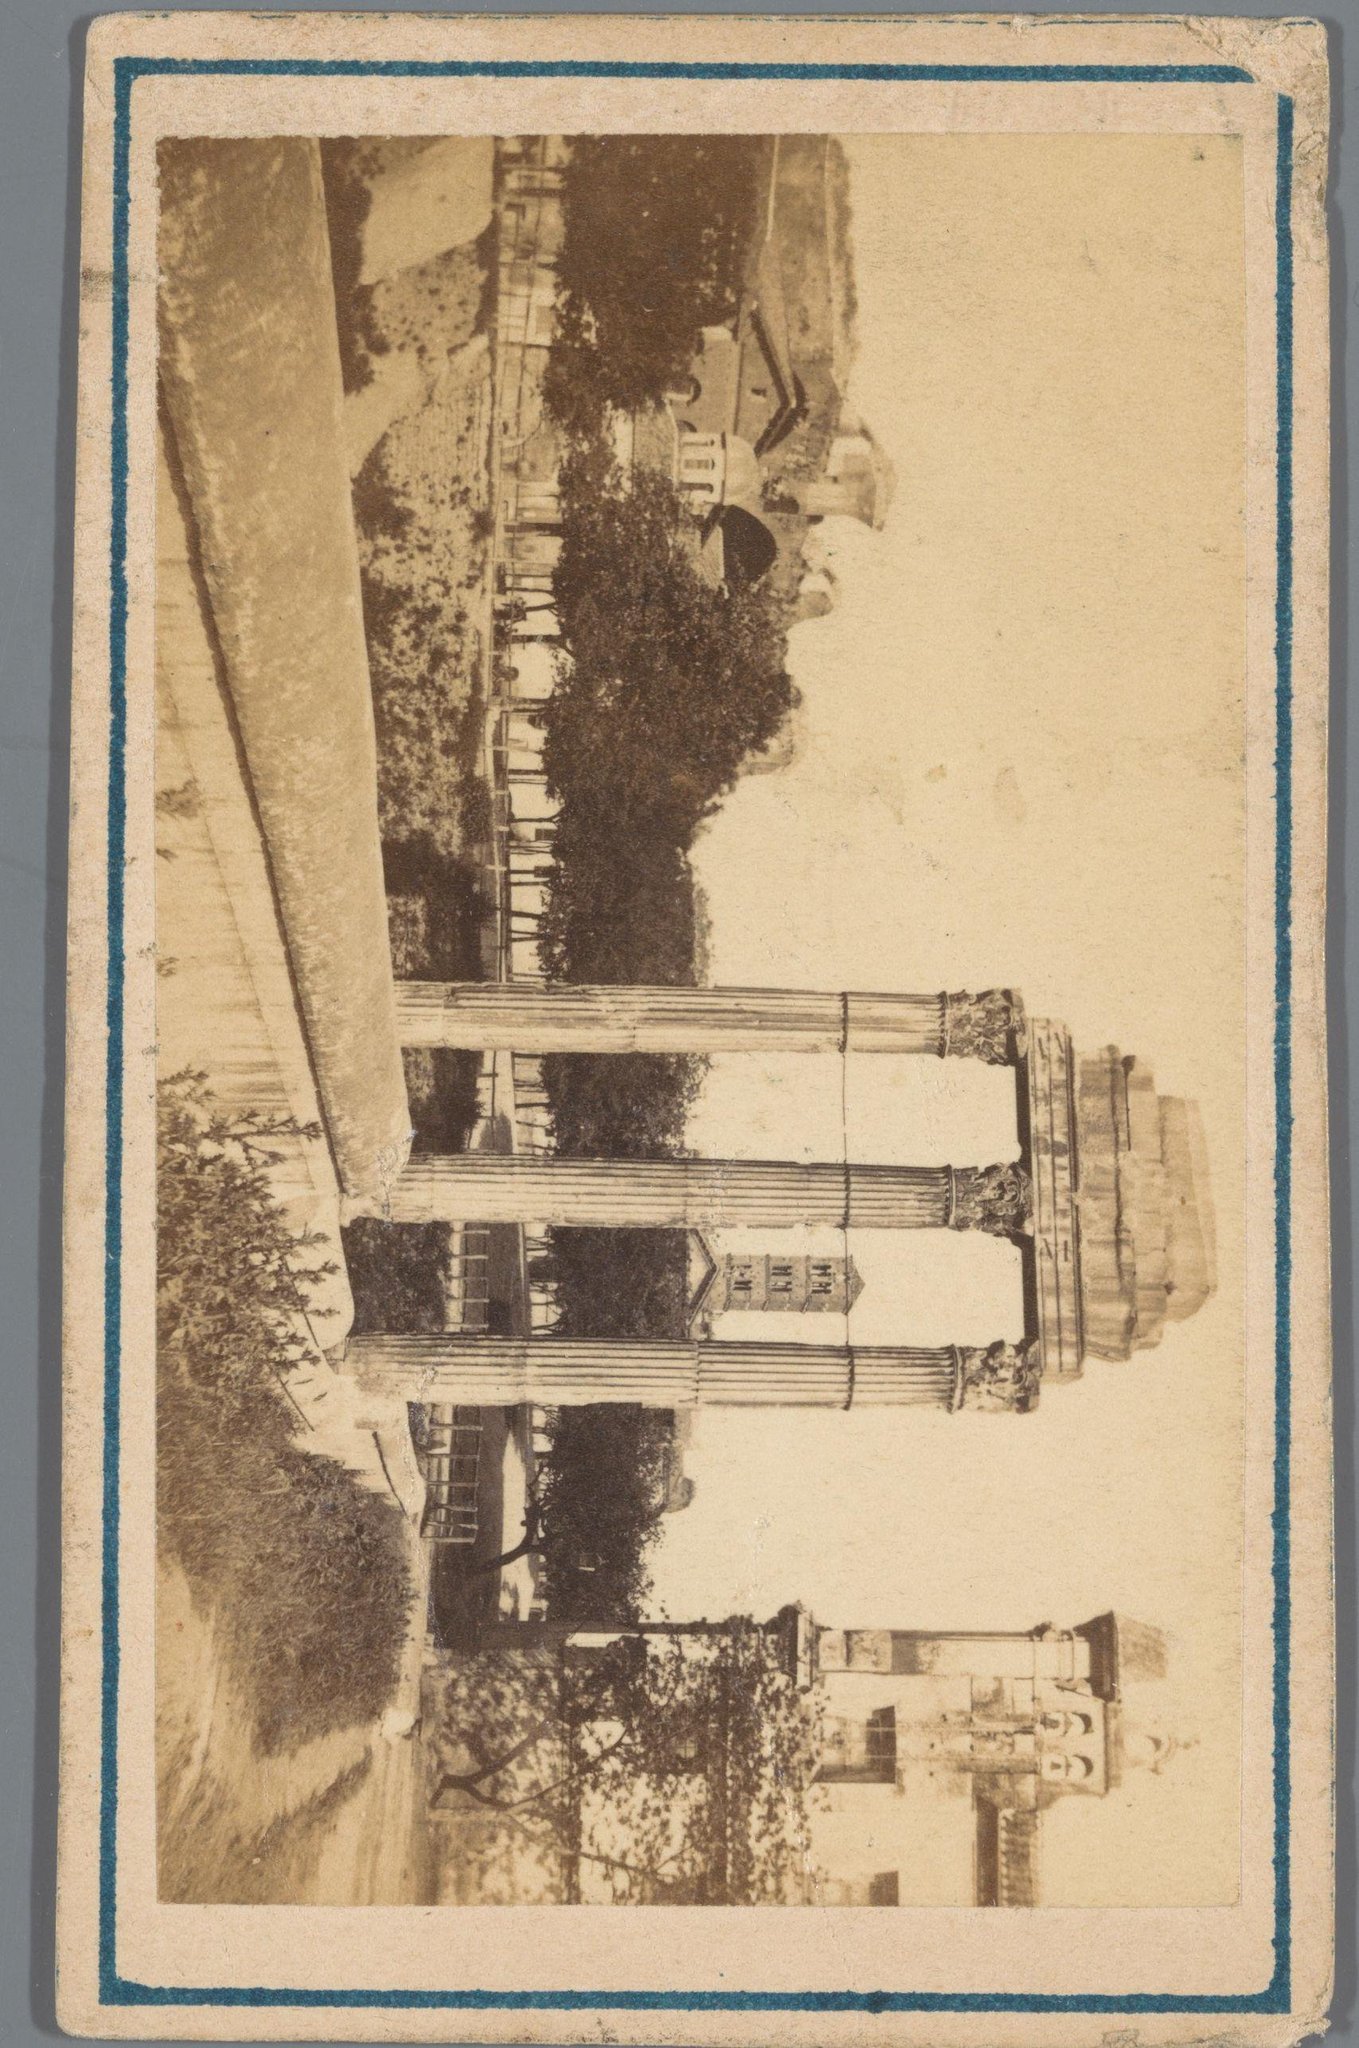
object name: carte de visite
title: Forum de Roma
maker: Anonymous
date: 1855-1885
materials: cardboard, paper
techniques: albumen print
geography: rome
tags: column, pillar ~ architecture, ruin of a building ~ architecture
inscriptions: inscription: ‘Salle de ambassade - à Rome’